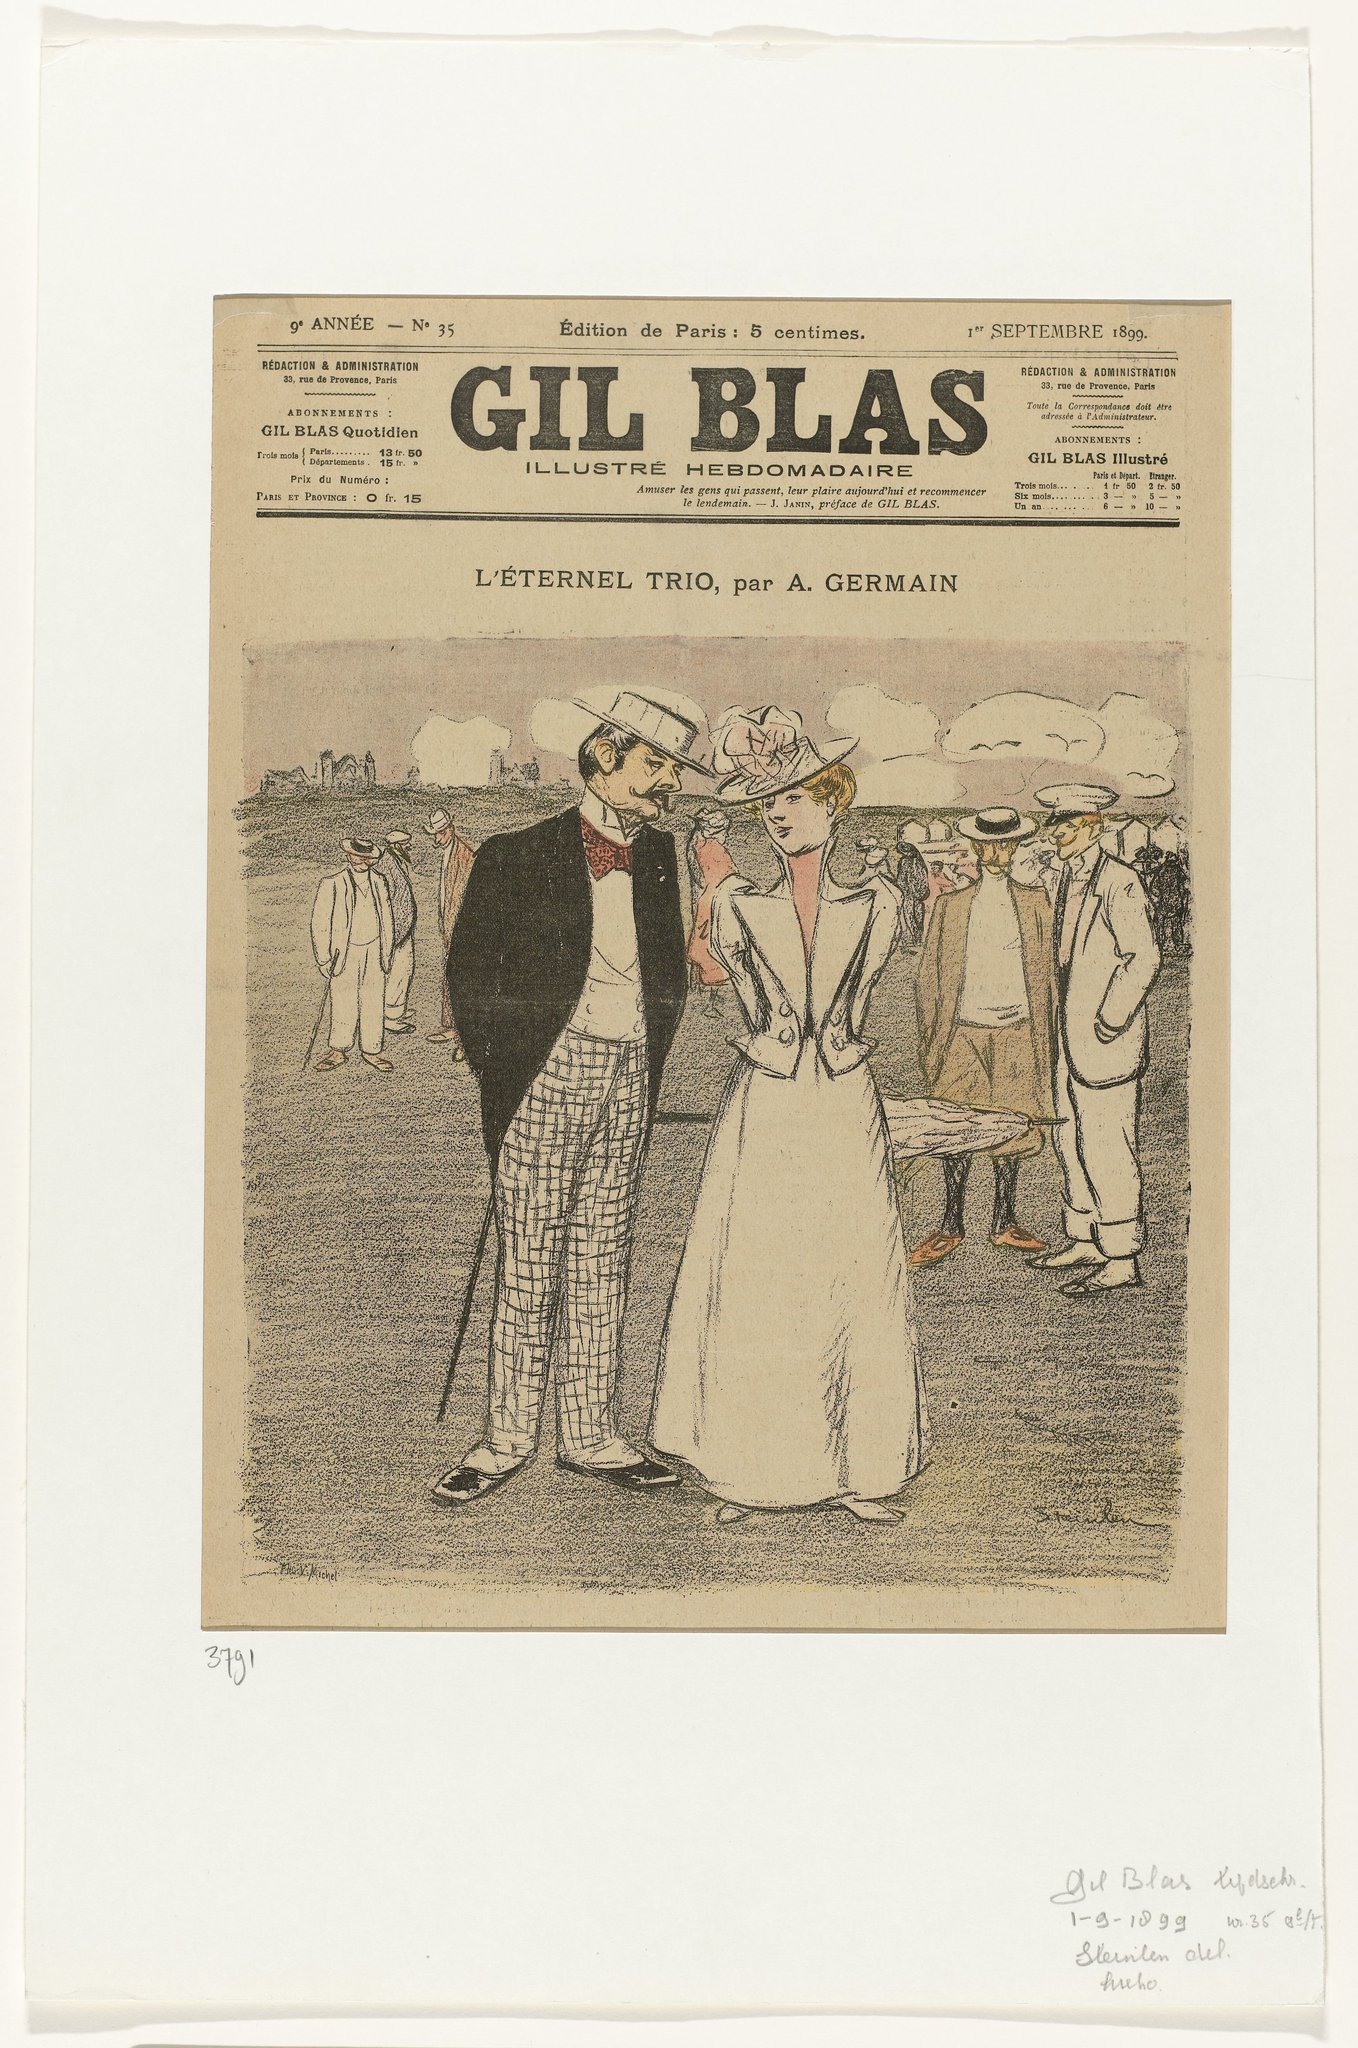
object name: fashion print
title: Gil Blas 1 Septembre 1899, No. 35, 9e année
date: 1899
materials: paper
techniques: hand coloring, lithograph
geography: paris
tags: fashion plates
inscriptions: date